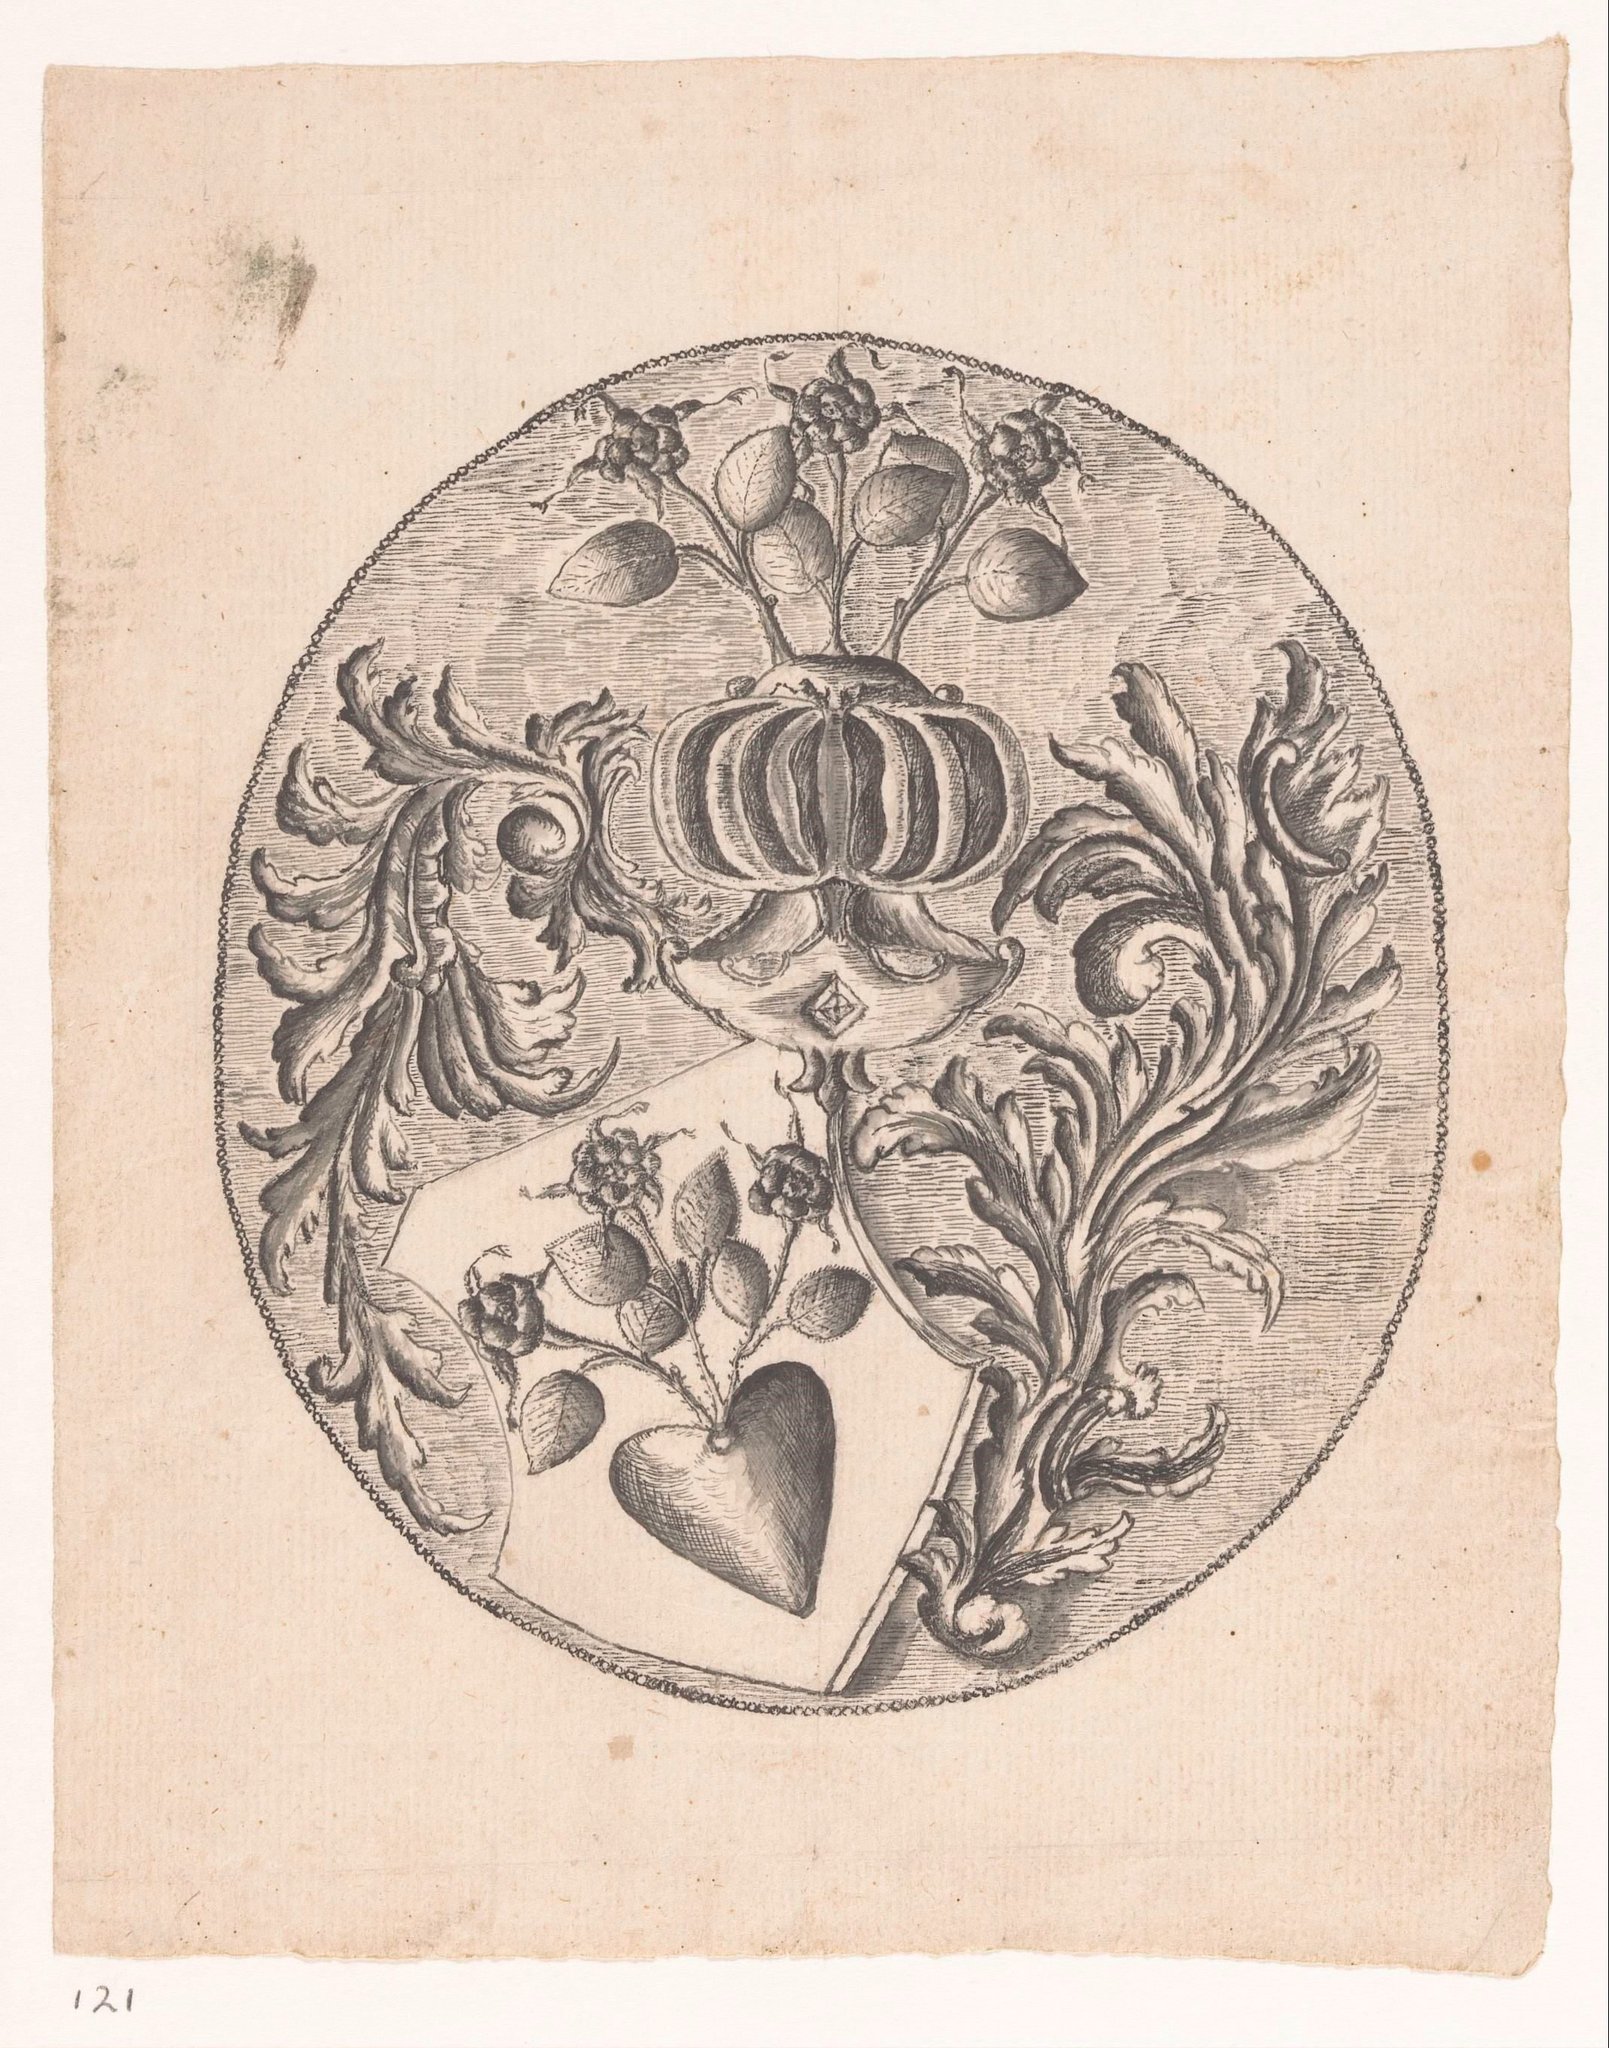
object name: drawing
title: Familiewapen met roos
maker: jan brandes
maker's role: draughtsman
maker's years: 1743-1808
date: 1770-1808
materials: ink, paper, pencil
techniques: brush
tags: armorial bearing, heraldry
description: Medaillon met een familiewapen met een roos groeiend vanuit een hart.